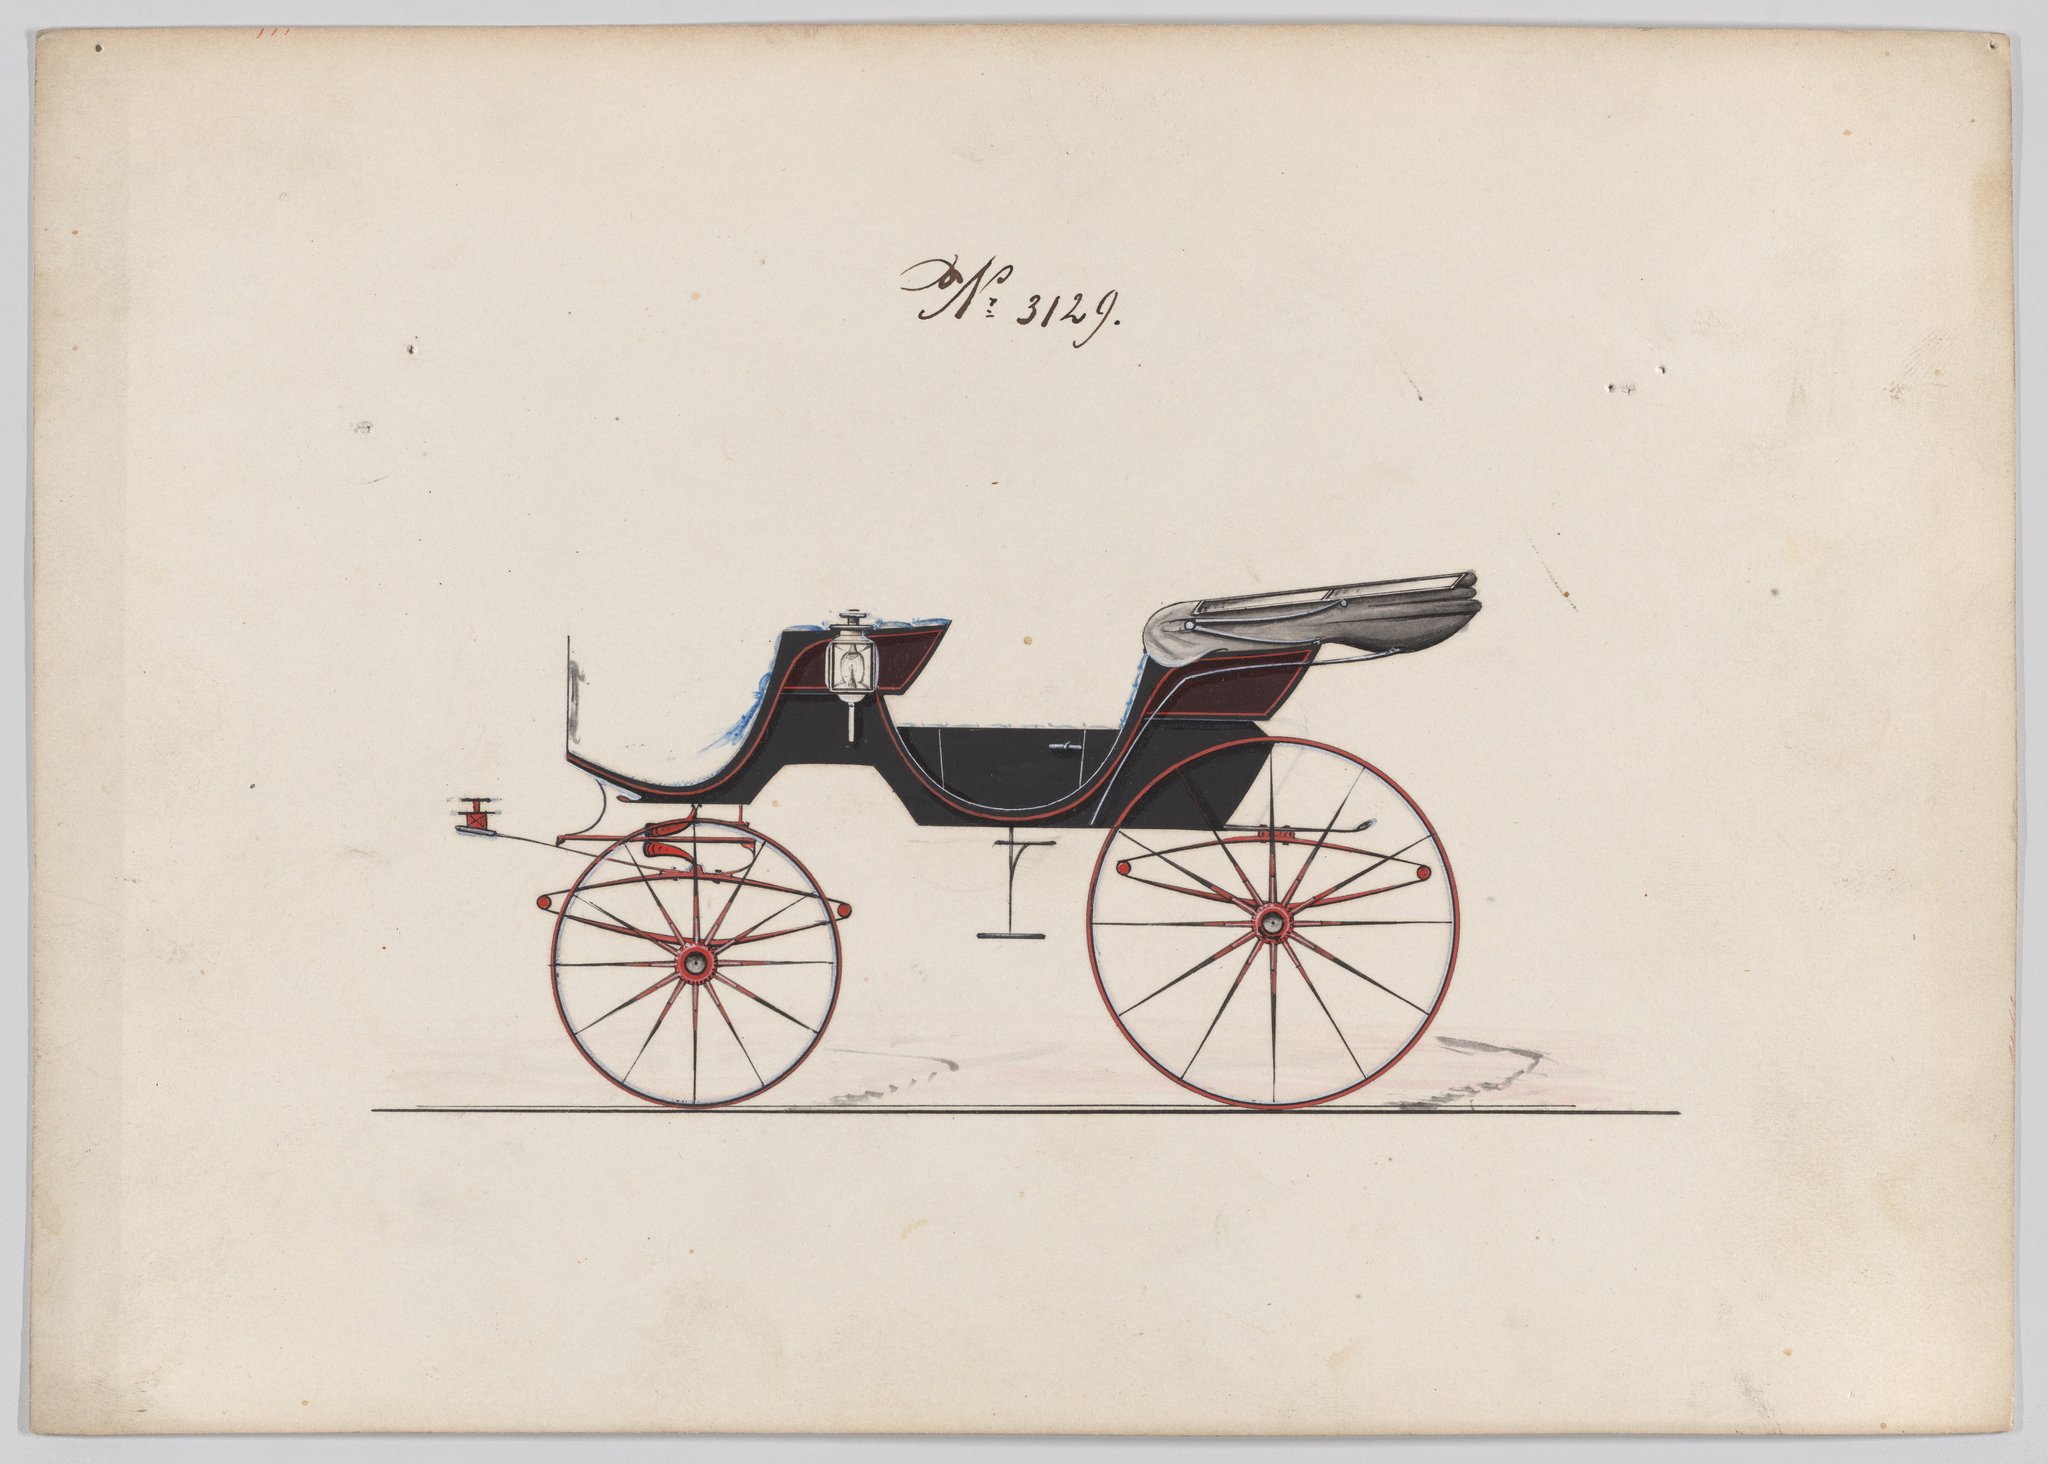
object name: drawing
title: Design for 2 seat Cabriolet Phaeton, no. 3129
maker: brewster & co.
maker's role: manufacturer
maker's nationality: american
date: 1875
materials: gouache, gum arabic, ink, watercolor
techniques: pen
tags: carriages